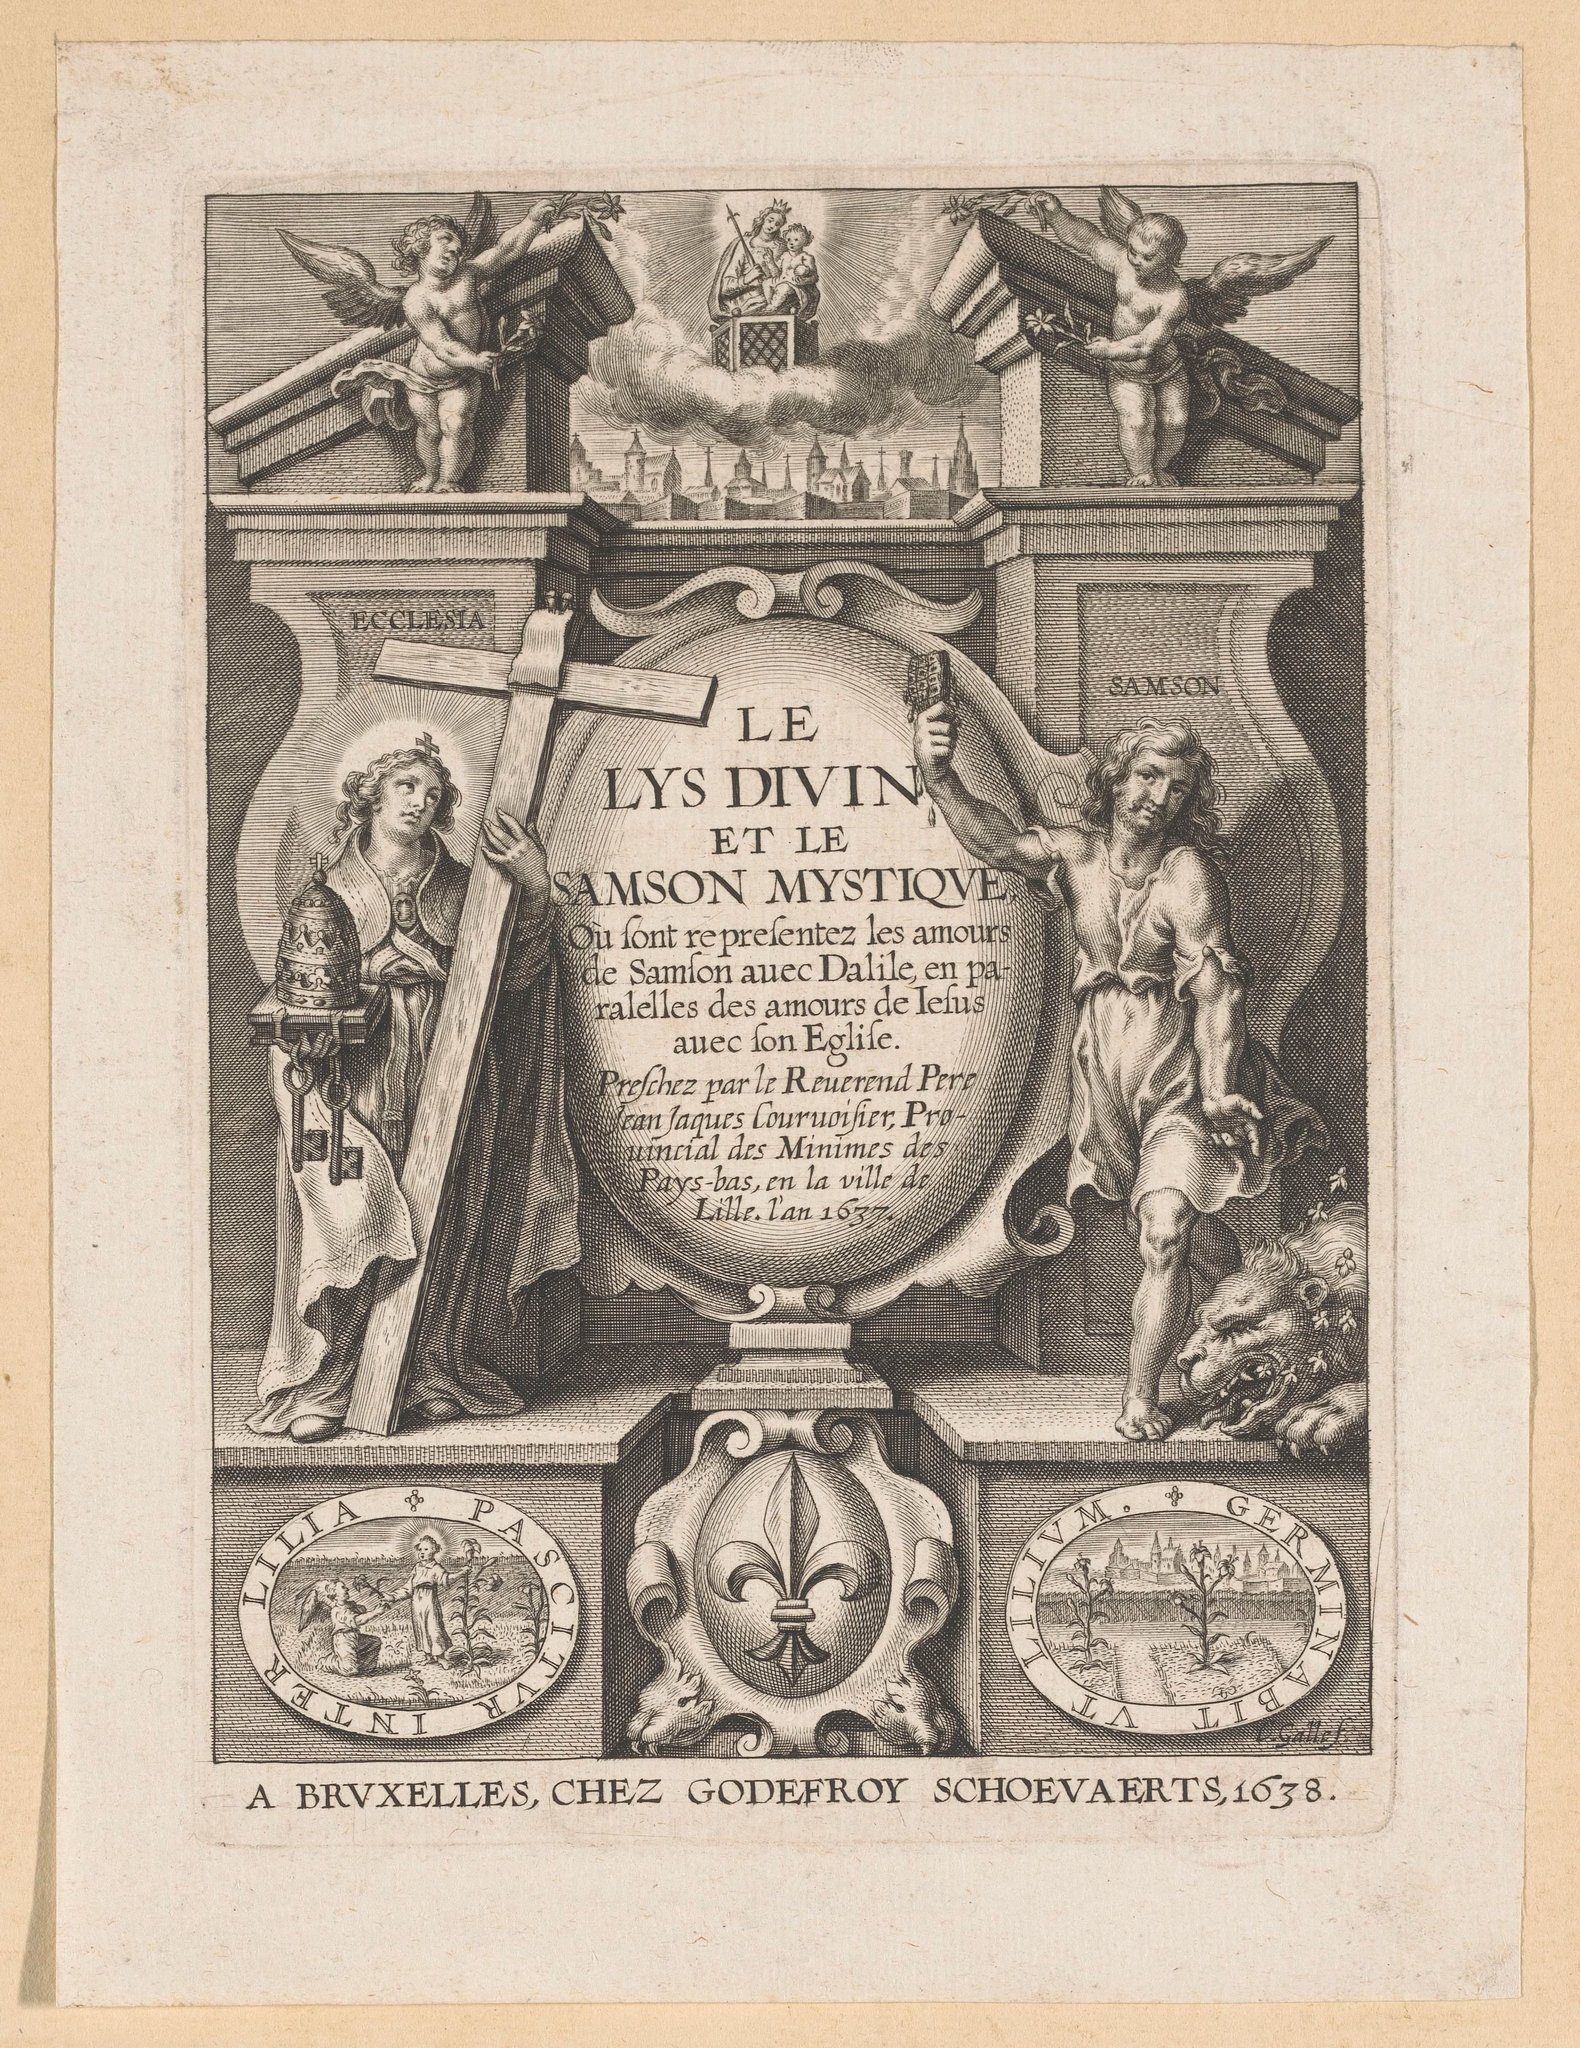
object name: titelblad, titelpagina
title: Titelpagina voor: Jean Jaques Courvoisier, Le Lys divine et le Samson mystique, Brussel: 1638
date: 1638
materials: paper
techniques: engraving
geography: southern netherlands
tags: coat of arms (as symbol of the state, etc.), samson finds a swarm of bees in the lion's body (+ variant), the church personified, 'ecclesia', usually with chalice and banner, flowers: lily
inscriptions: collector's mark: Lugt 240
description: De personificatie van de Kerk, met kruis en symbolen van de pauselijke macht, staat tegenover Simson die de leeuw een honingraat afpakt. Onder een wapen met de Franse lelie en twee medaillons met voorstellingen van lelies. Titelillustratie voor een boek met preken.